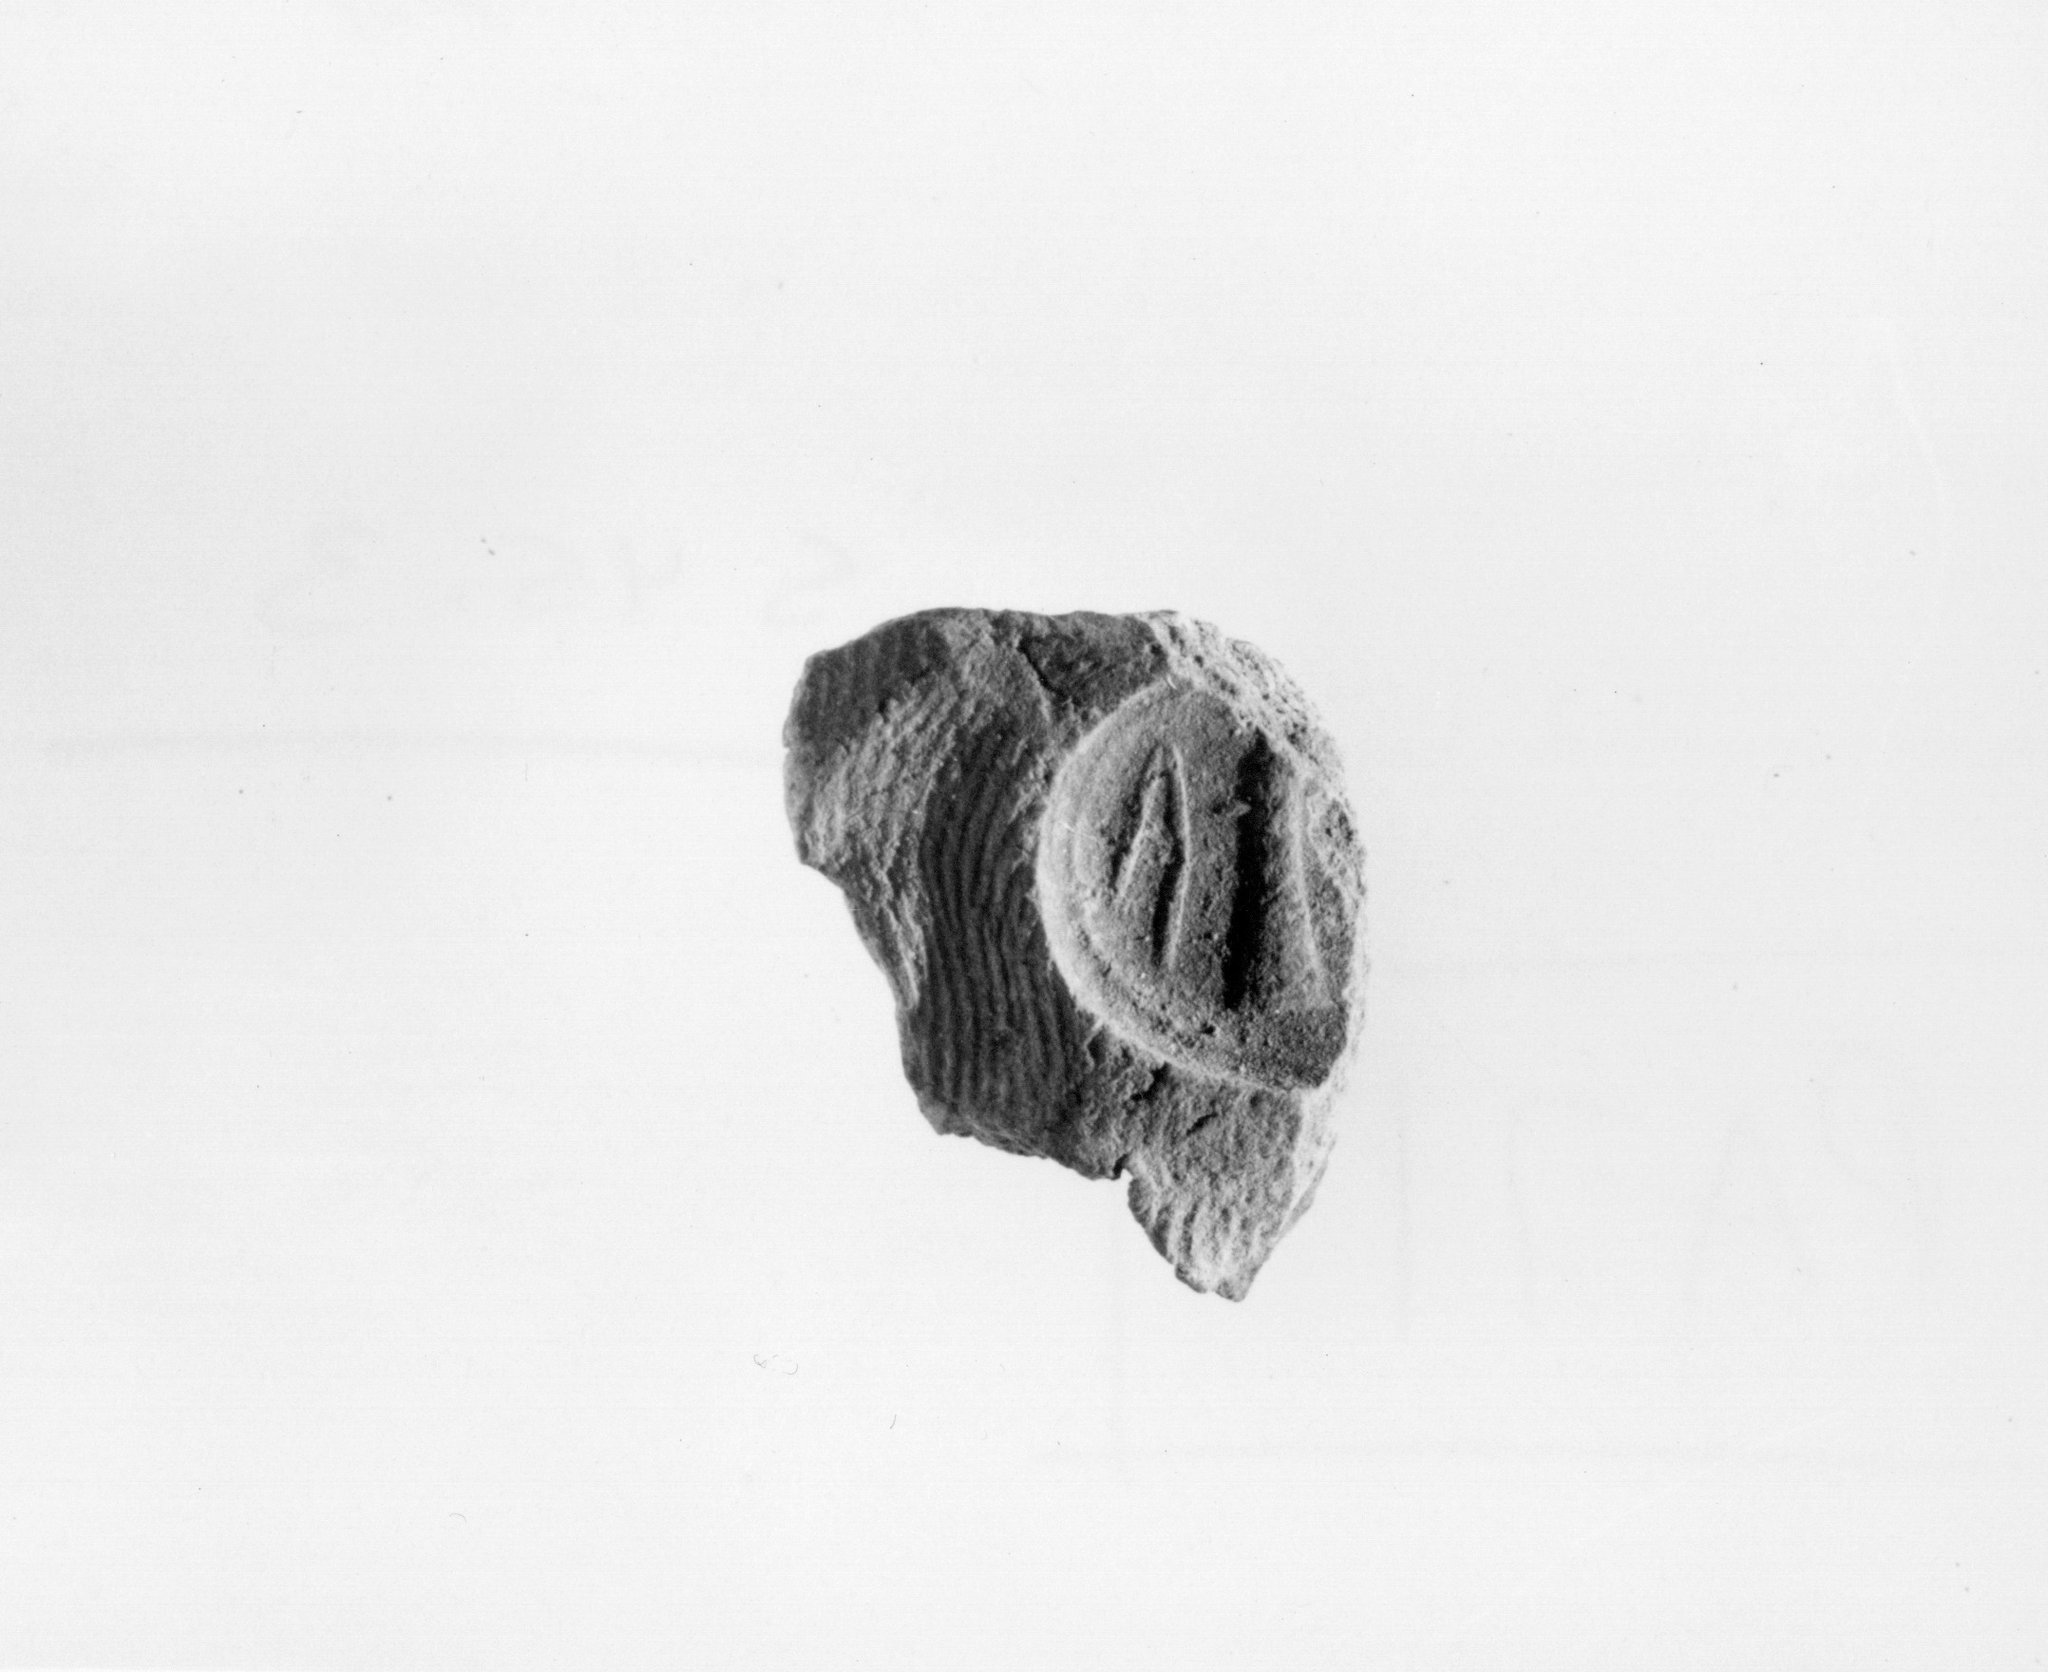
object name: sealing, nebmaatre, amenhotep iii, heb sed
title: Document Sealing With the Throne Name of Amenhotep III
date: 1390-1352 BCE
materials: mud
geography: egypt